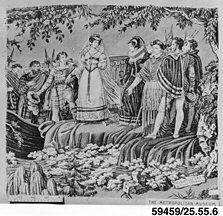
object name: piece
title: Marie Stuart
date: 1825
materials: linen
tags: men,women,flowers,leaves